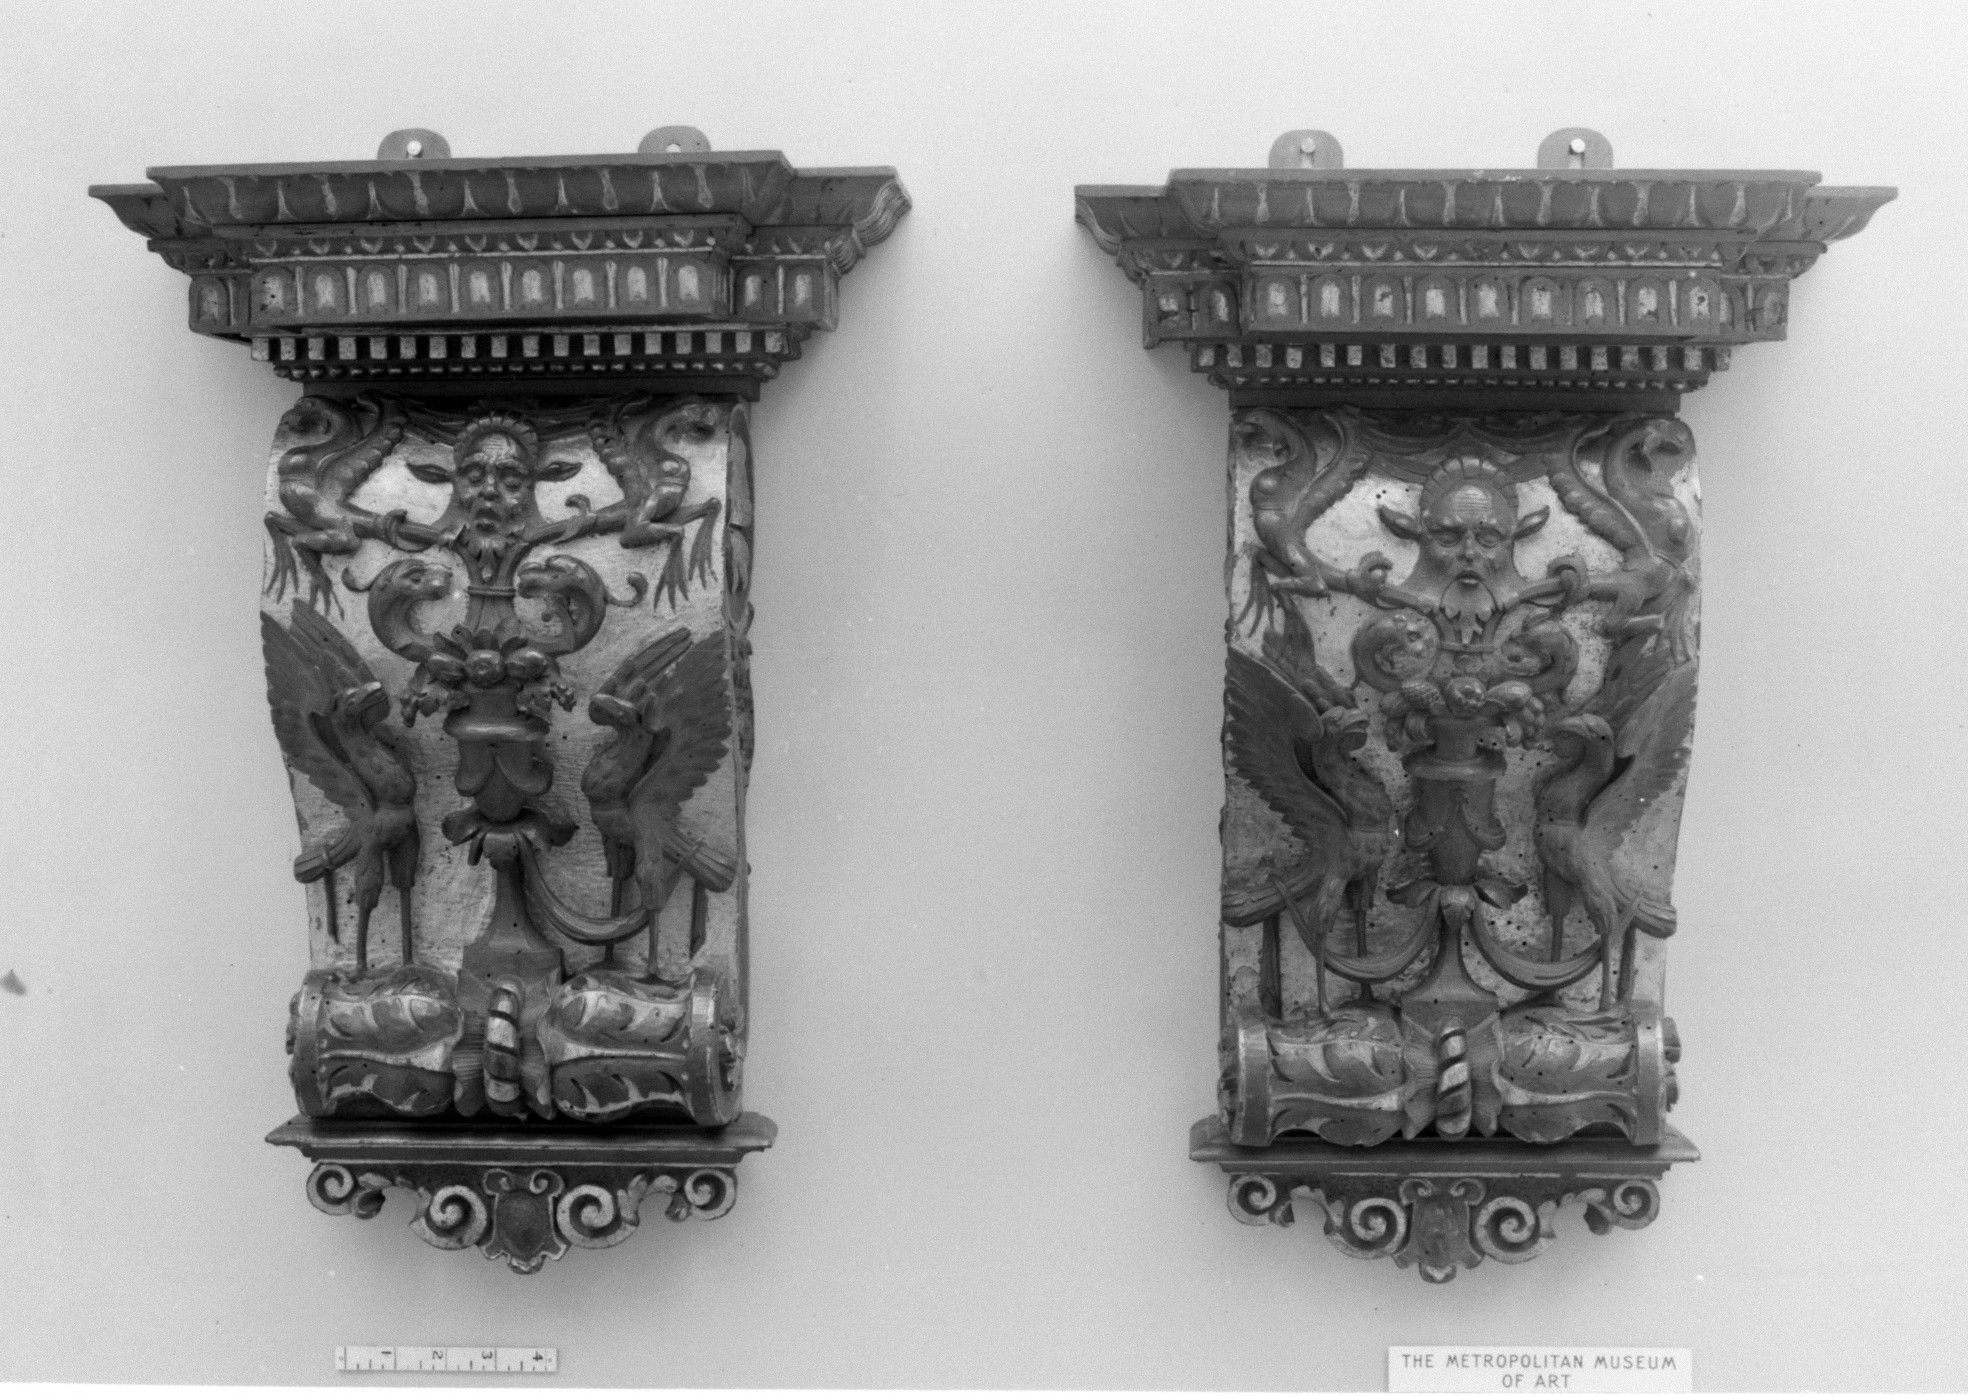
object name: bracket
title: Pair of brackets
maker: antonio barile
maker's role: maker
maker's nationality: italian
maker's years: 1452-1516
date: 1501-1600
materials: wood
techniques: carving, gilding